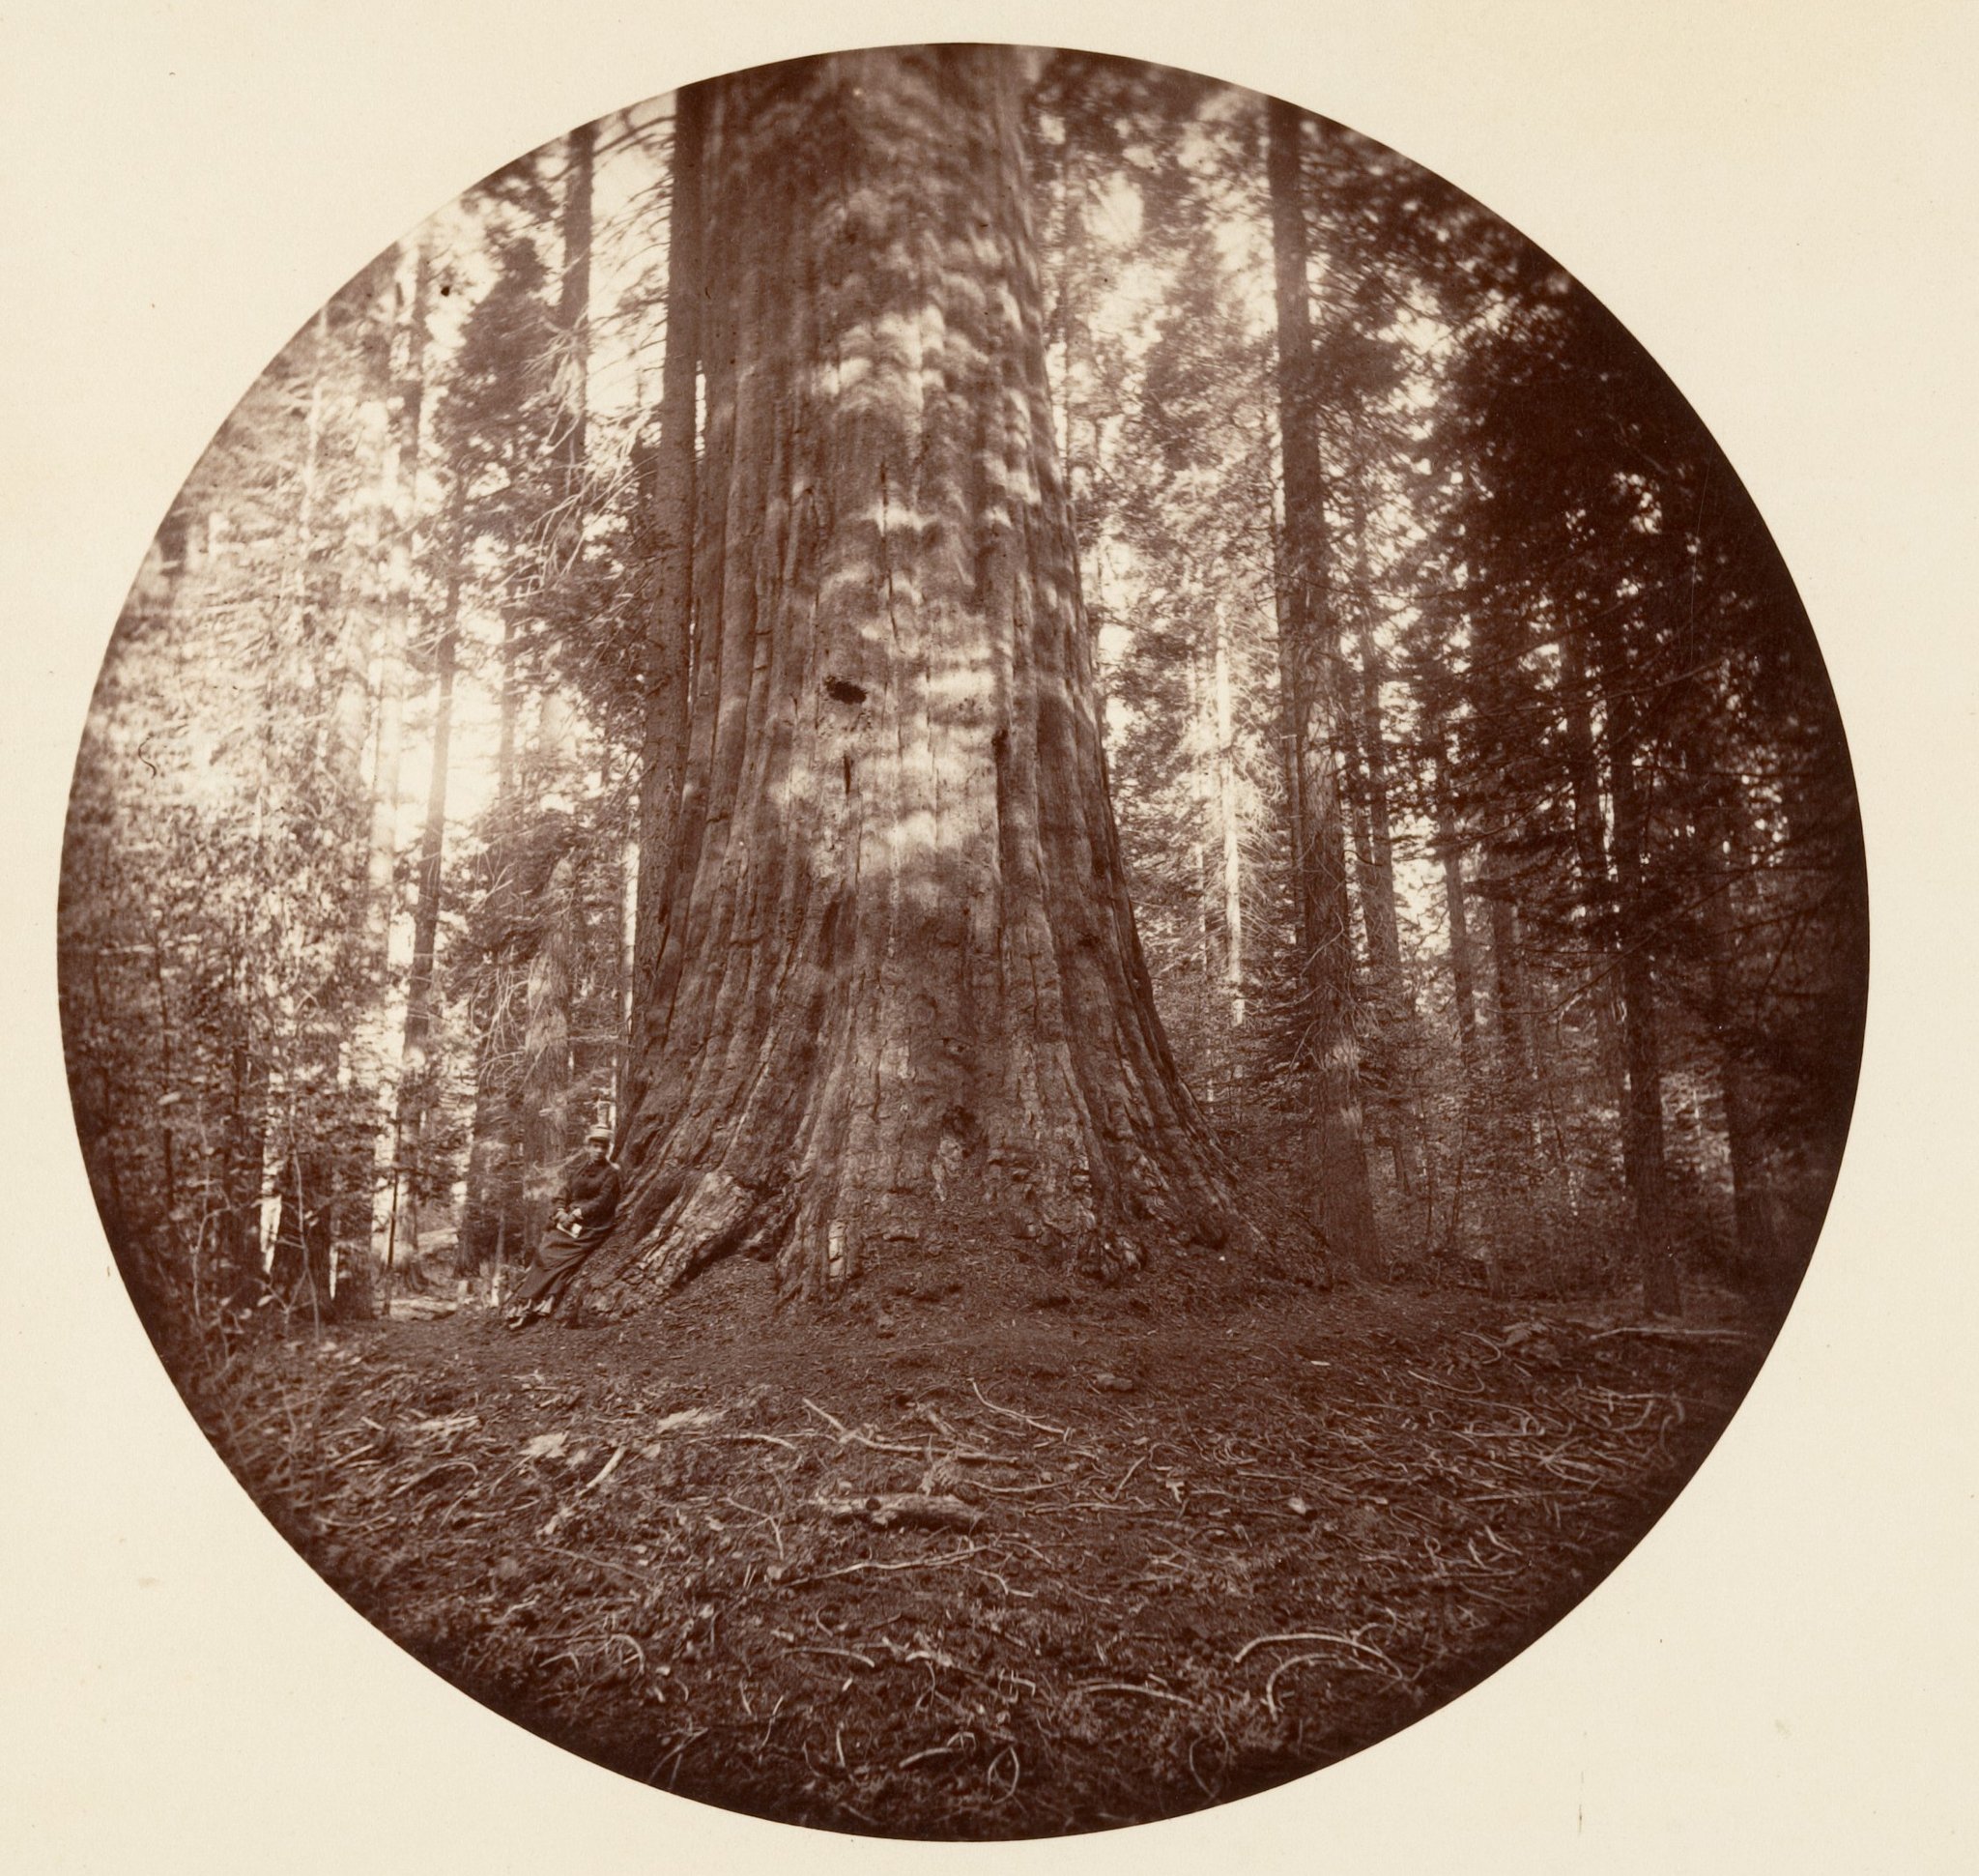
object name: photograph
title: Empire State. C. Grove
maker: carleton e. watkins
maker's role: artist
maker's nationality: american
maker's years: 1829-1916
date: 1878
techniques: albumen silver print, glass negative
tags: forests,trees